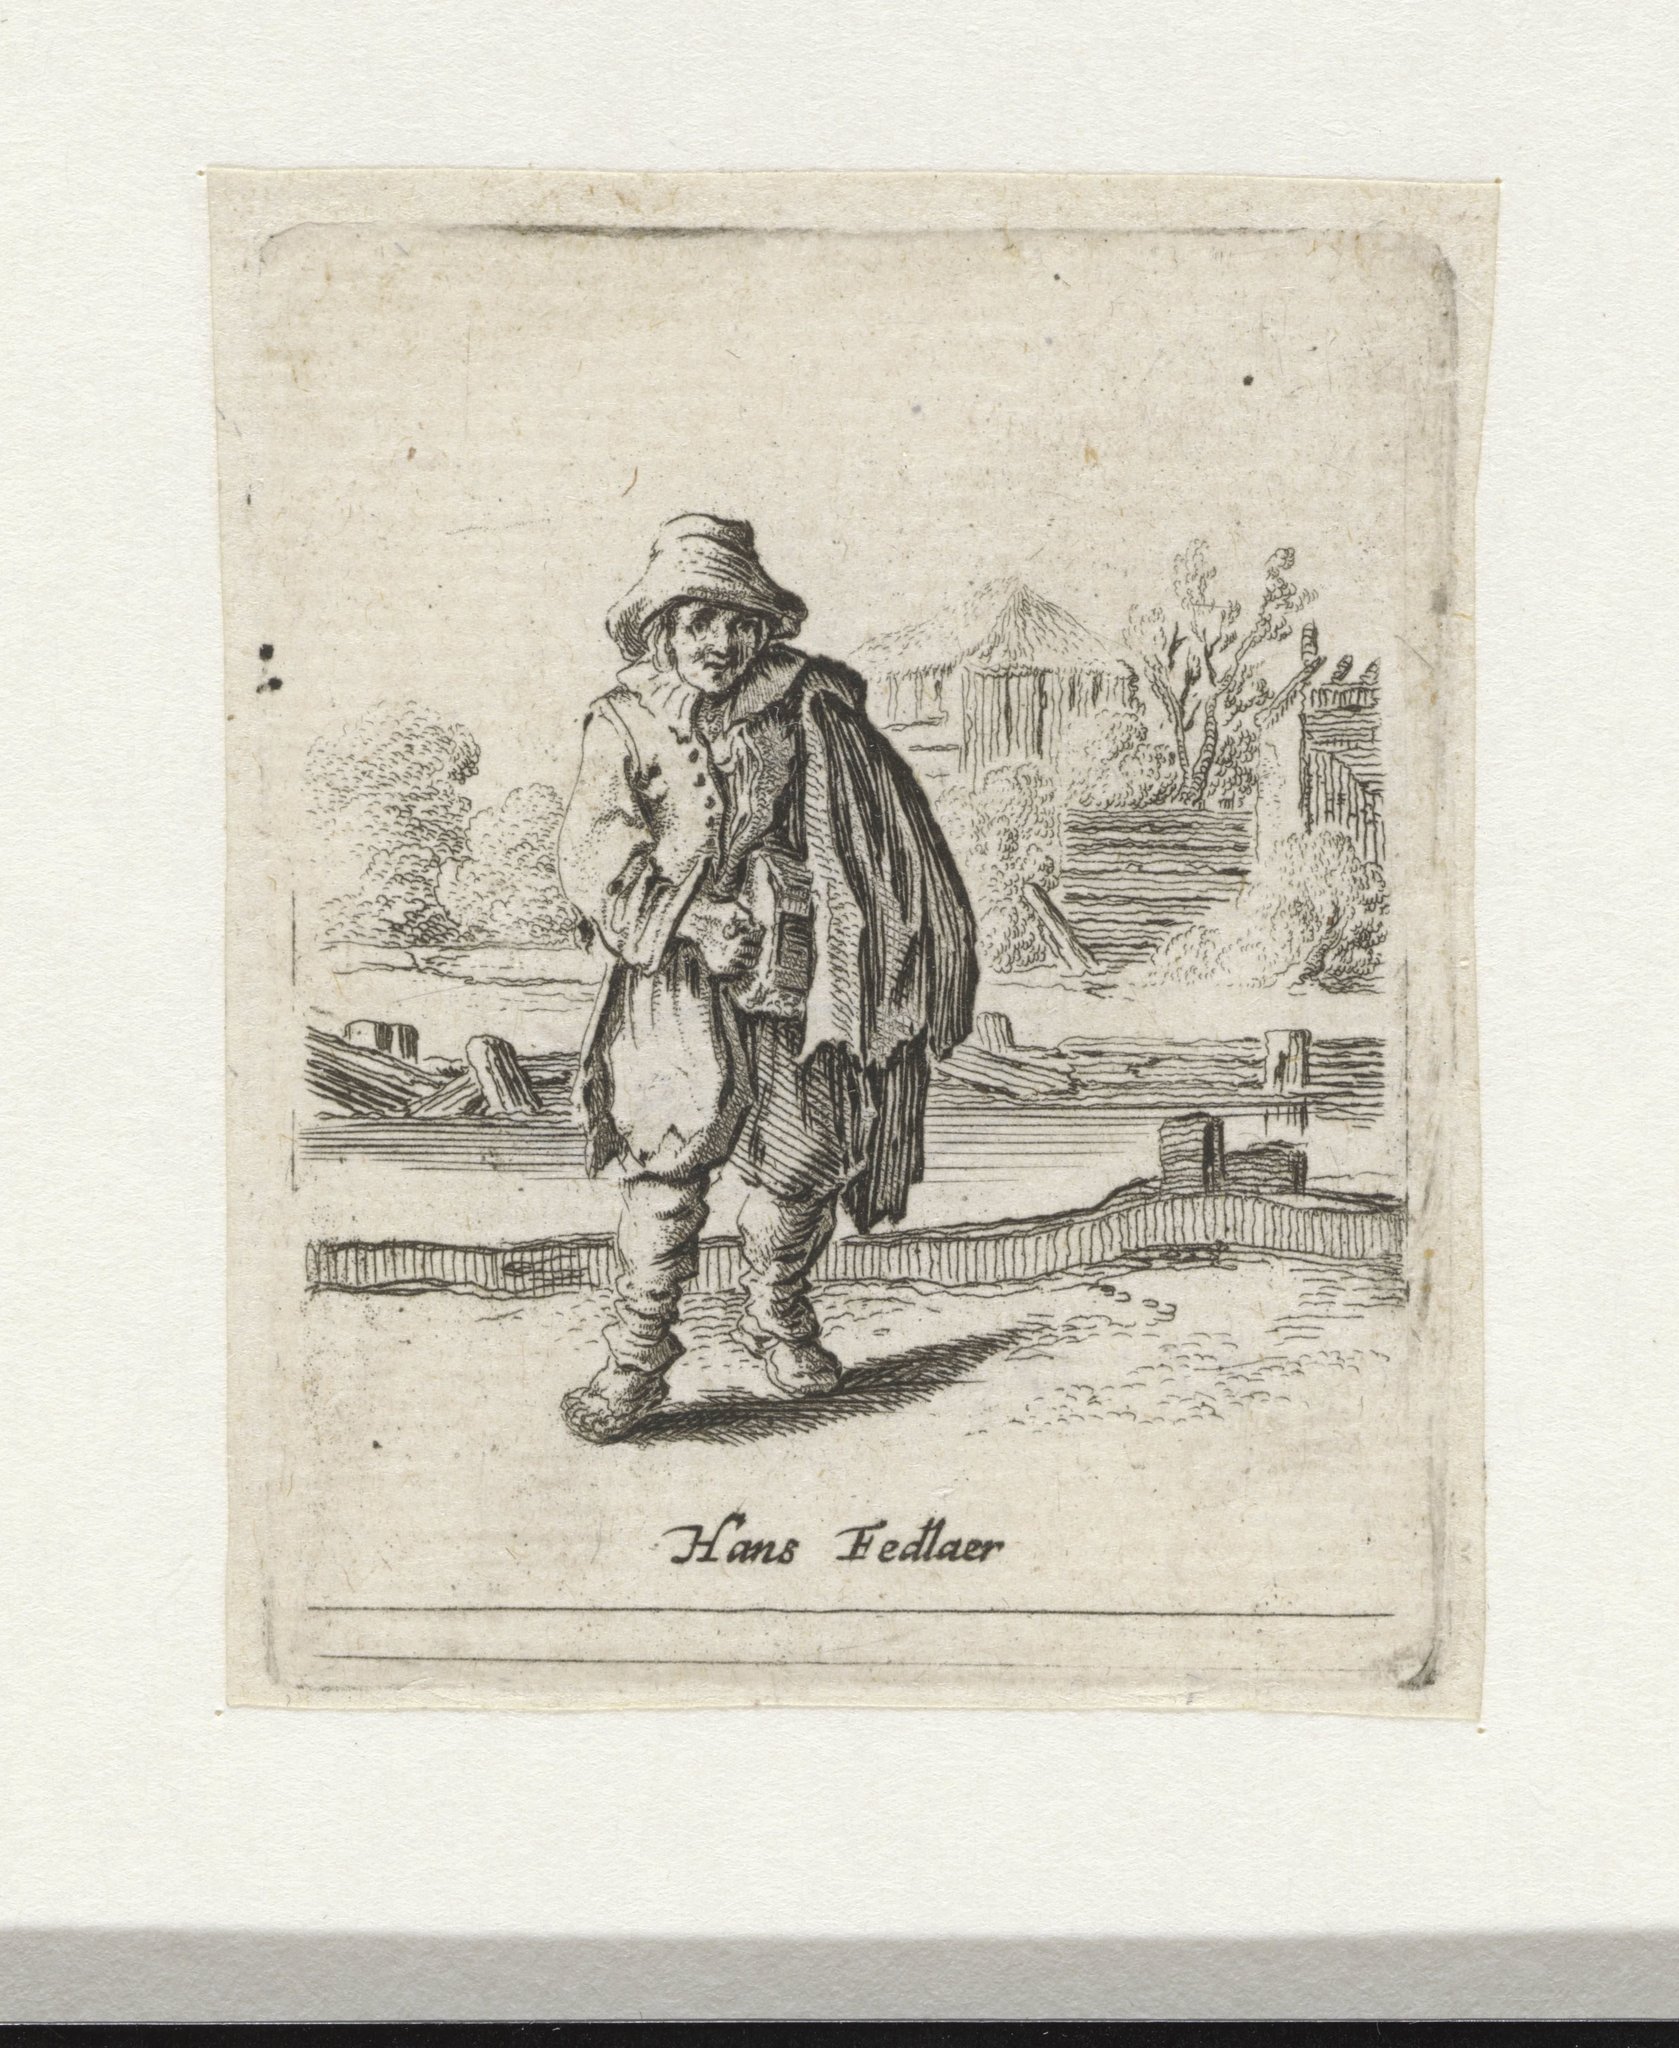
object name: print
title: Hans Fedlaer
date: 1638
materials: paper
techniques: etching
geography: amsterdam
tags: instrumental popular music - cc - out of doors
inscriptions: collector's mark: Lugt 2228, collector's mark: Lugt 2760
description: Een jonge man (Hans Fedlaer) draagt een cape en bespeelt een muziekinstrument. Op de achtergrond een vaart en een huis tussen de bomen. De prent maakt deel uit van een serie van 32 prenten met genretaferelen.